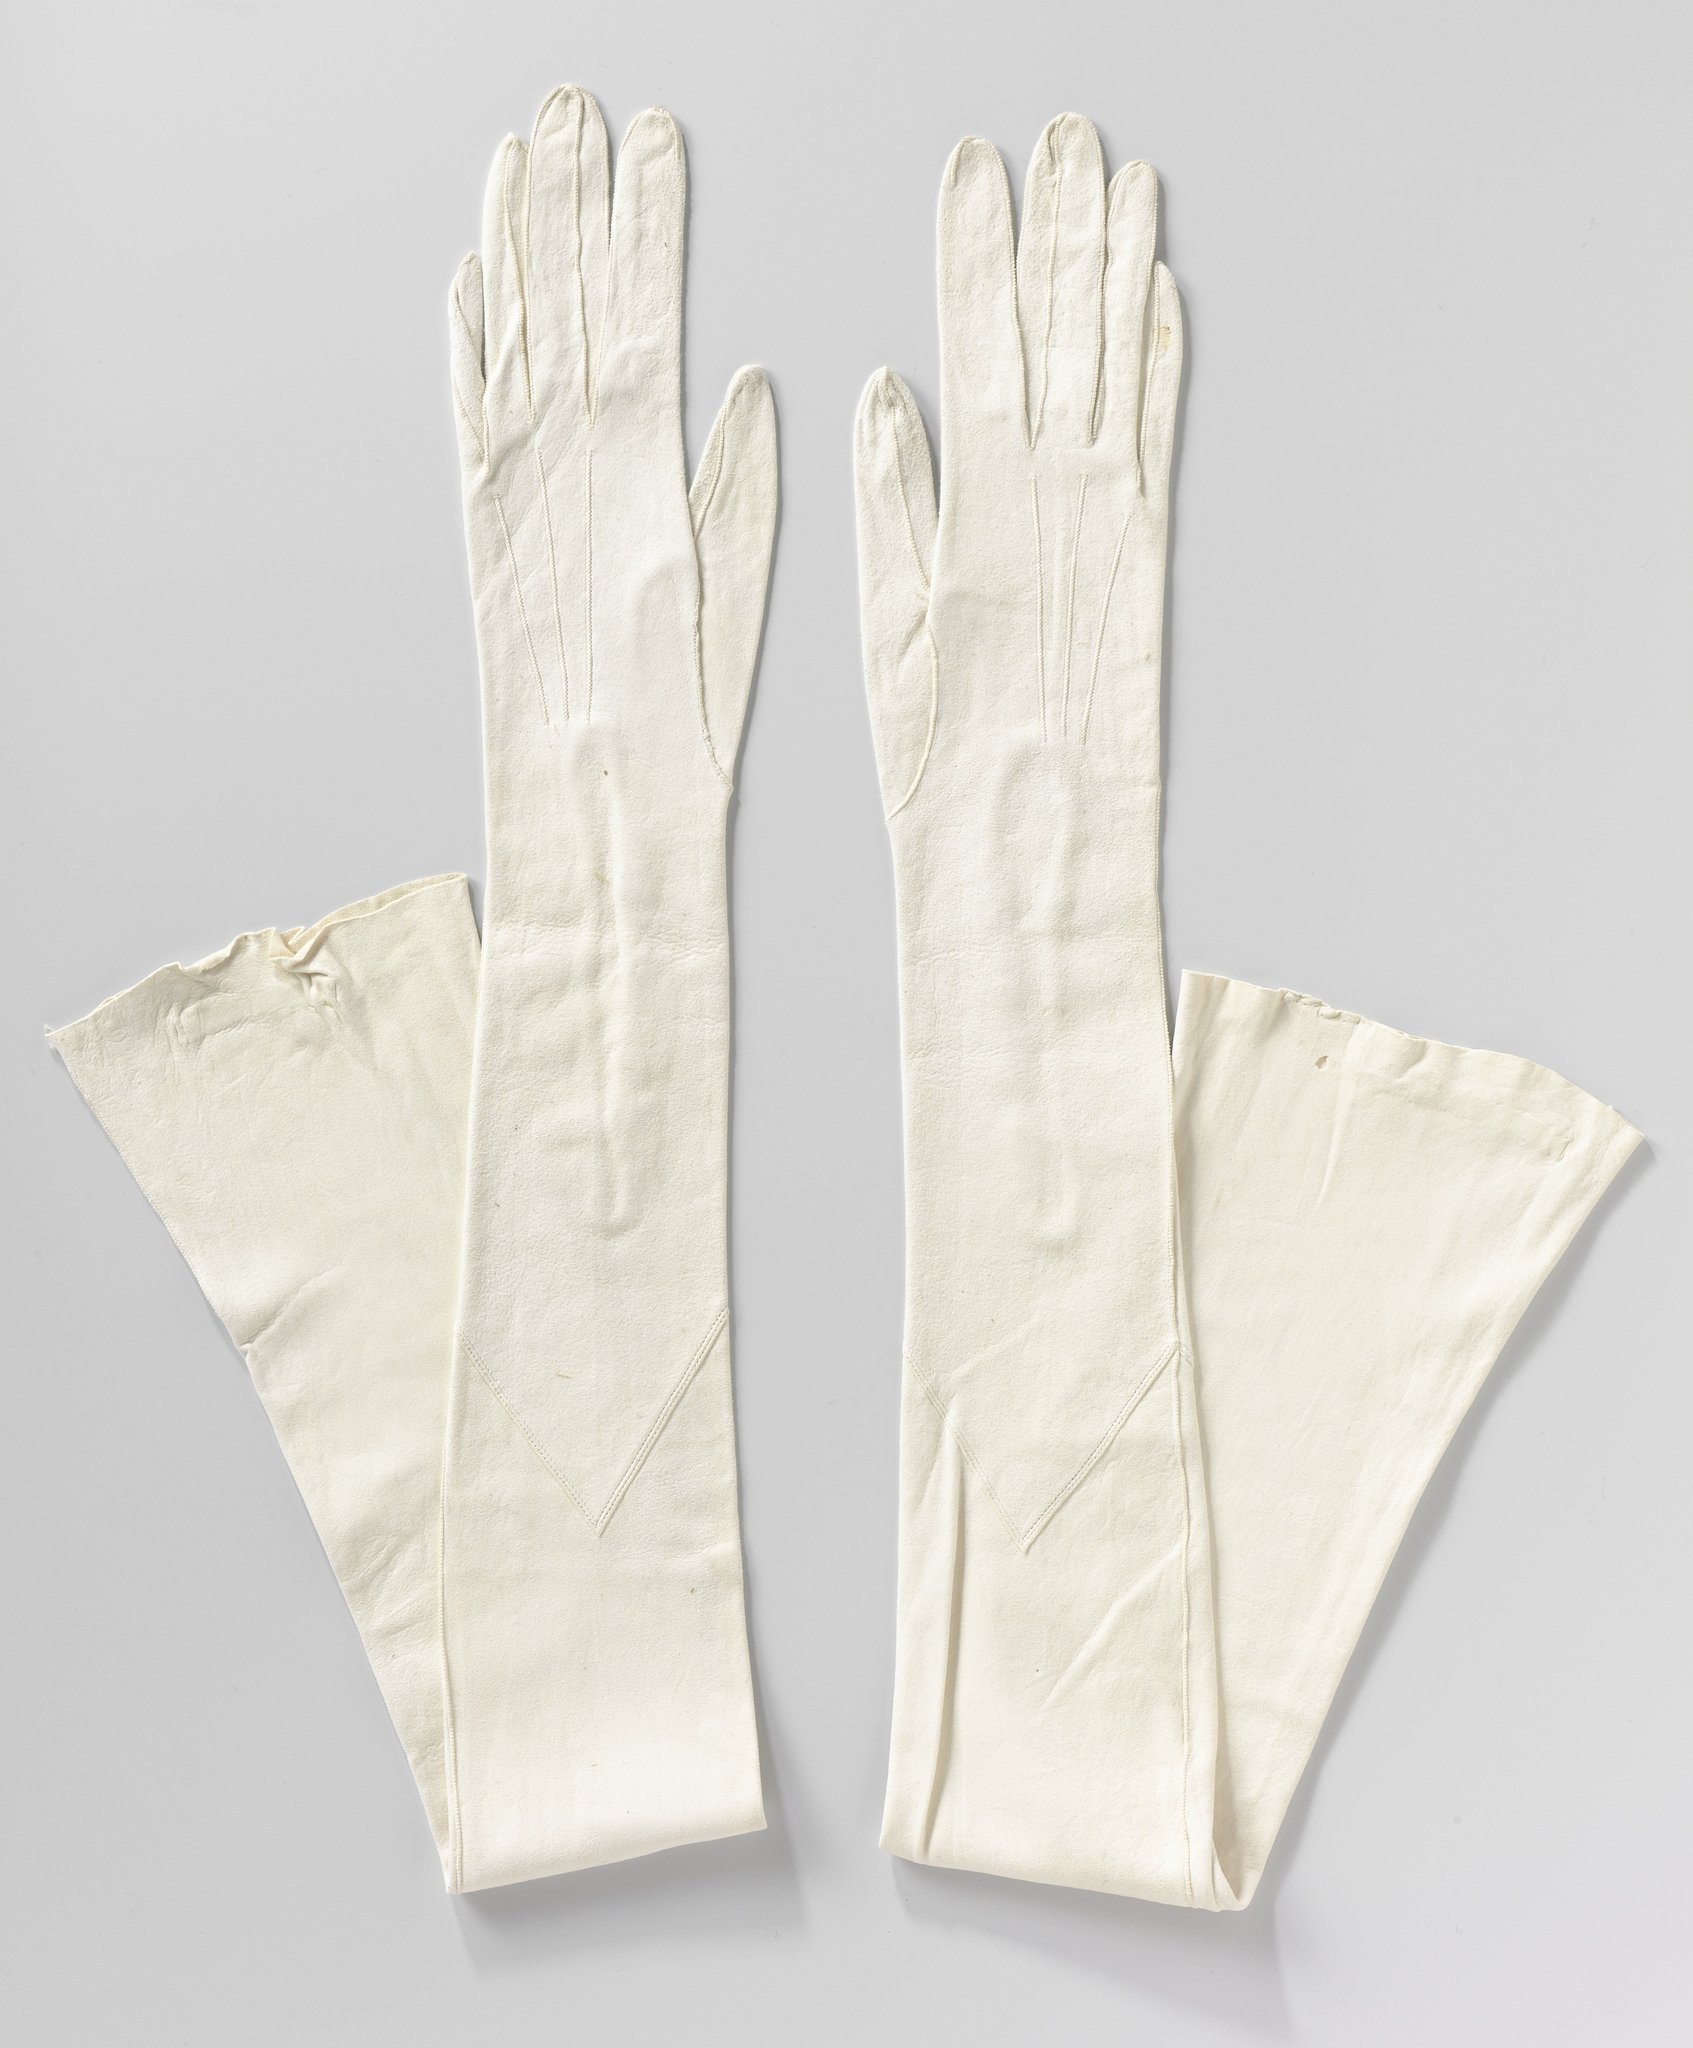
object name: glove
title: Handschoen, galahandschoen, van wit wasleer met sluiting van parelmoeren knoopjes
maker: m. laimböck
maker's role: modehuis, modewarenhuis, modewinkel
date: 1930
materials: leather, mother of pearl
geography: amsterdam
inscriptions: name: ‘M. Laimböck’, address: ‘Gants Lavable/ Laimböck/ Tyrol, Amsterdam/ K. Hofleverancier’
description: Linker handschoenen van wit wasleer, met sluiting van vier parelmoeren knopen. Nauwsluitend model, tot over de gehele bovenarm. Onder de elleboog een puntig sierstiksel. Adres: Gant Lavable/ Laimböck/ Tyrol, Amsterdam / K. Hofleverancier / 6 3/4.